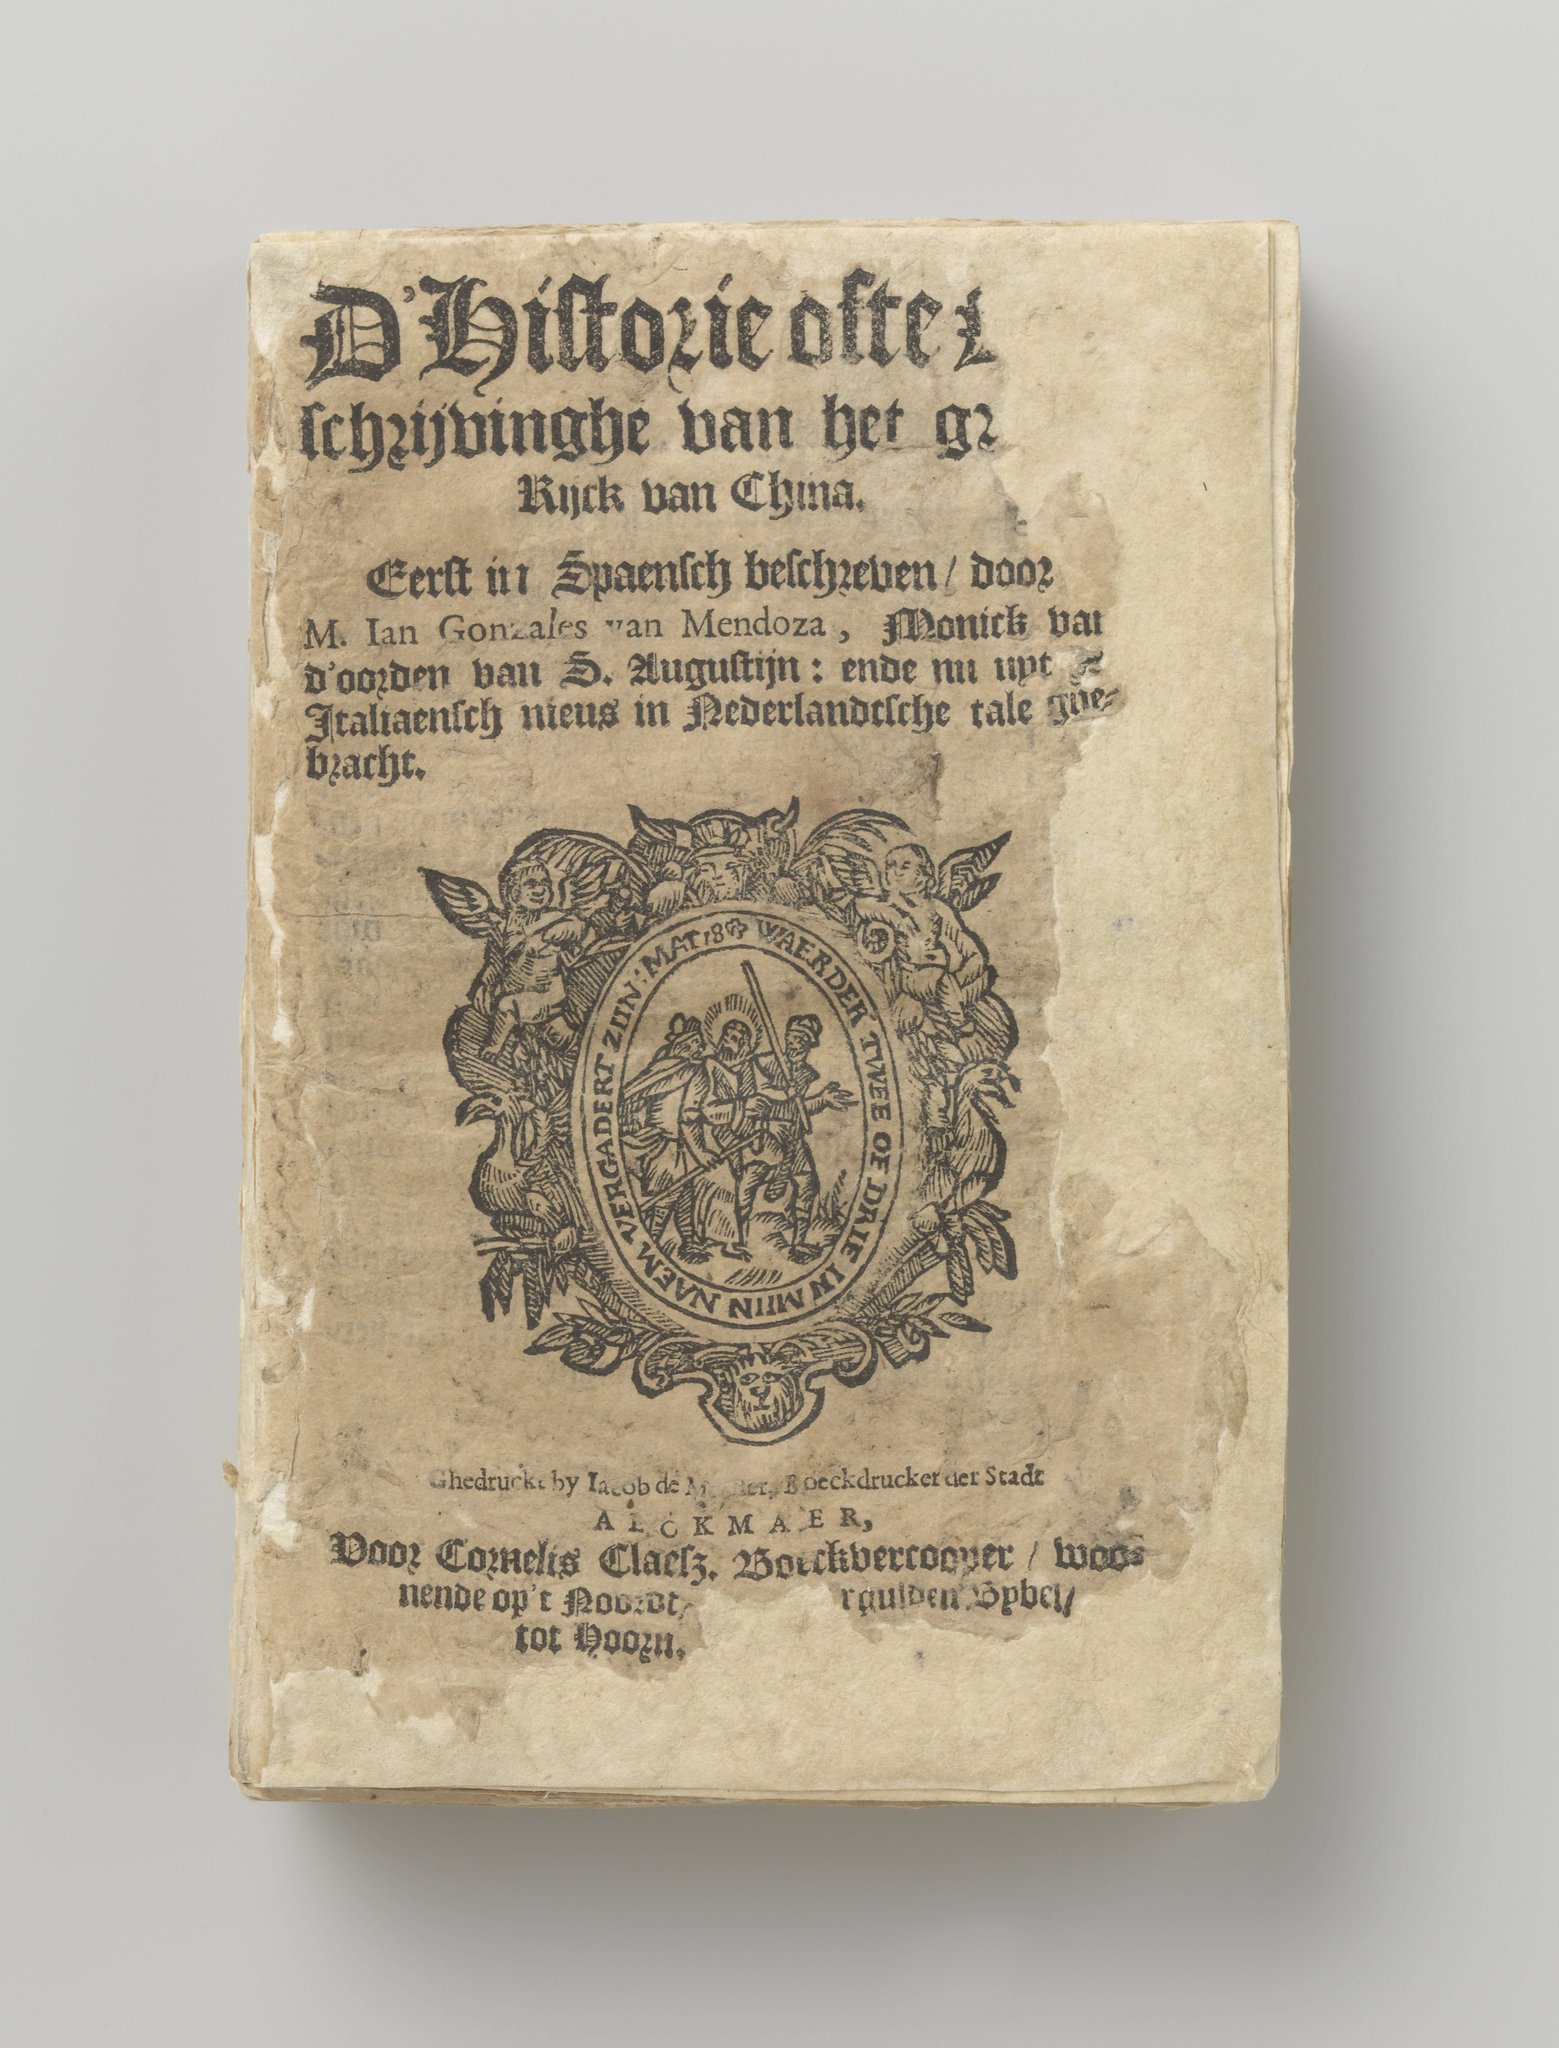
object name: book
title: Title page of the early guide to China, D' Historie ofte Beschrijvinghe van het groote Rijck China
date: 1595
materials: paper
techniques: printing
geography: hoorn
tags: willem barendsz., amsterdam, jacob van heemskerck, china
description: Boekje in bruin-rode losse (te kleine) perkamenten omslag, klein octaaf, in de vorm van een zakboekje. Het gaat over China, oudste Nederlandse editie, in Hoorn uitgegeven door Cornelis Claesz. Titel: "D' Historie ofte Beschrijvinghe van het groote Rijck van China". Eerst in Spaensch beschreven door M. Ian Gonzales van Mendoza, Monnick van d'oorden van S. Augustijn: ende nu uyt het Italiaenisch nieus in Nederlandtsche tale ghebracht...".